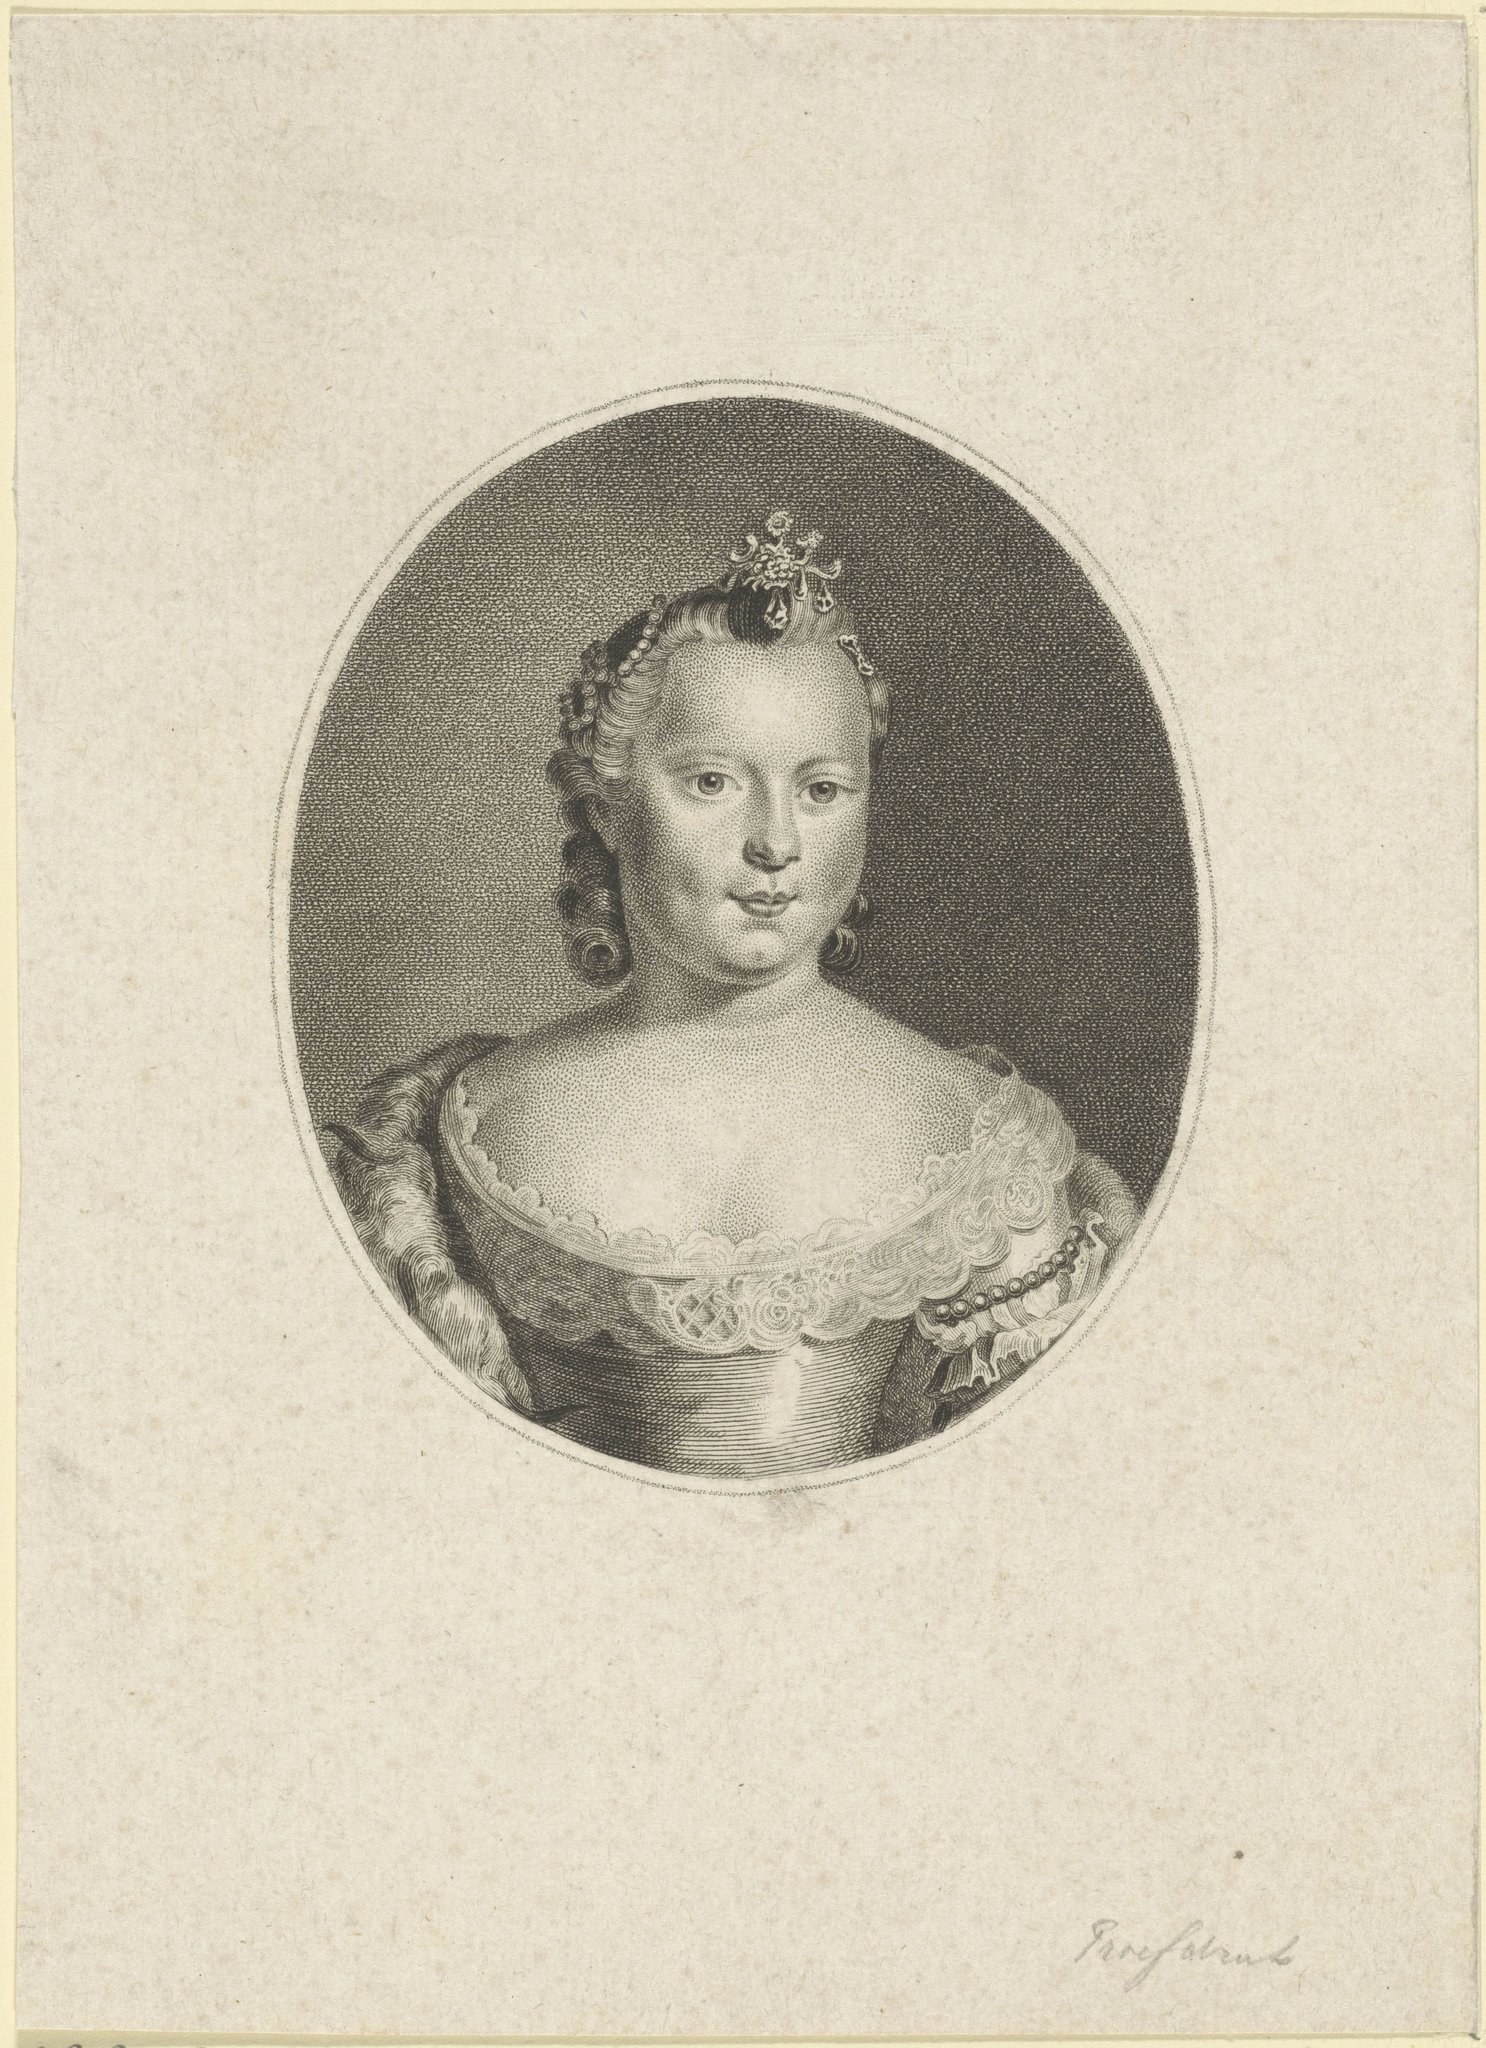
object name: print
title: Portret van Carolina, prinses van Oranje-Nassau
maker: willem van senus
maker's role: painter, print maker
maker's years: 1773-1851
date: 1787-1834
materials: paper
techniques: engraving, etching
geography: northern netherlands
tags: carolina (prinses van oranje-nassau)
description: De hier vermelde titel verwijst naar de hoogst verkregen titel van de geportretteerde, niet per se naar de titel die de geportretteerde op deze voorstelling draagt.